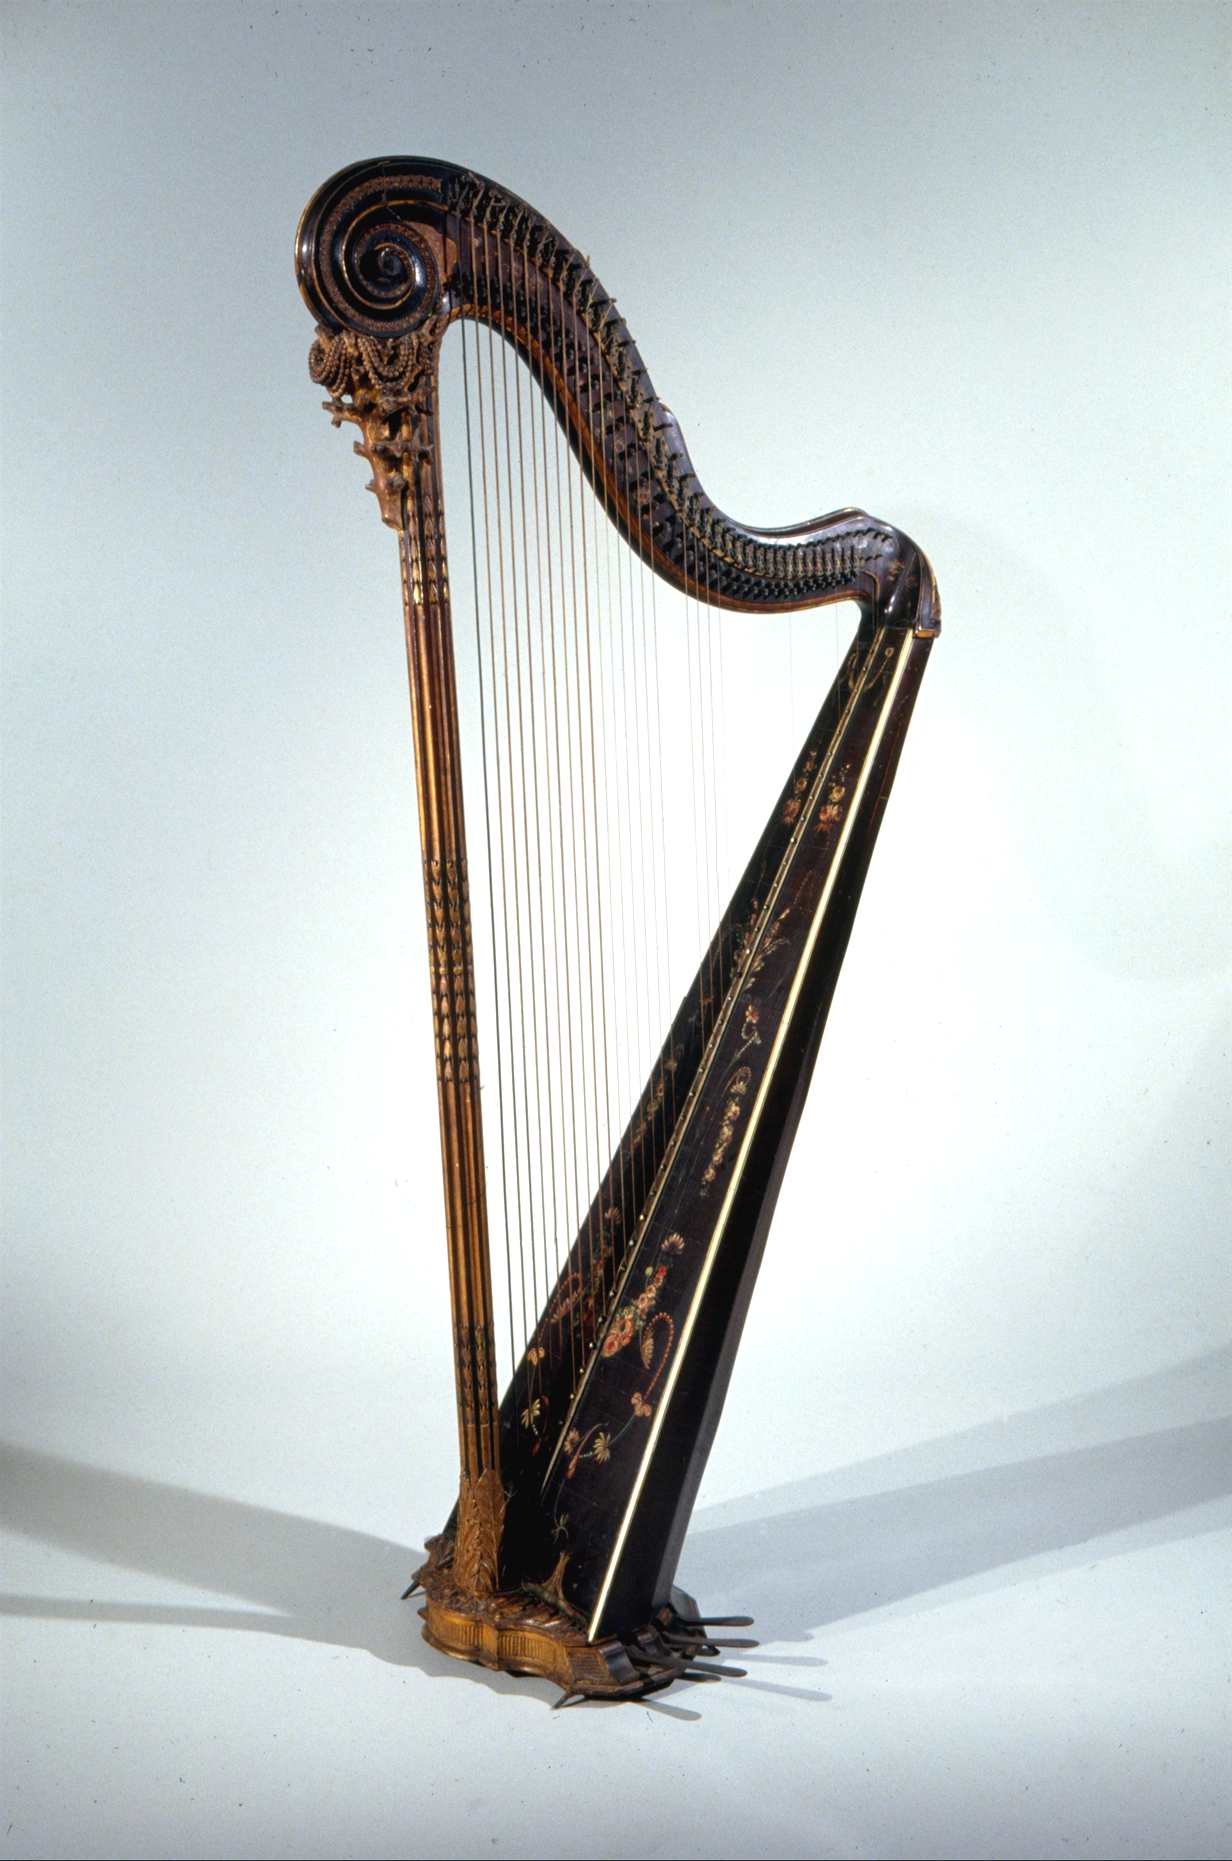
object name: pedal harp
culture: french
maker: cousineau père et fils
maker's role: maker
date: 1801-1833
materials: ivory, metal, wood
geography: france